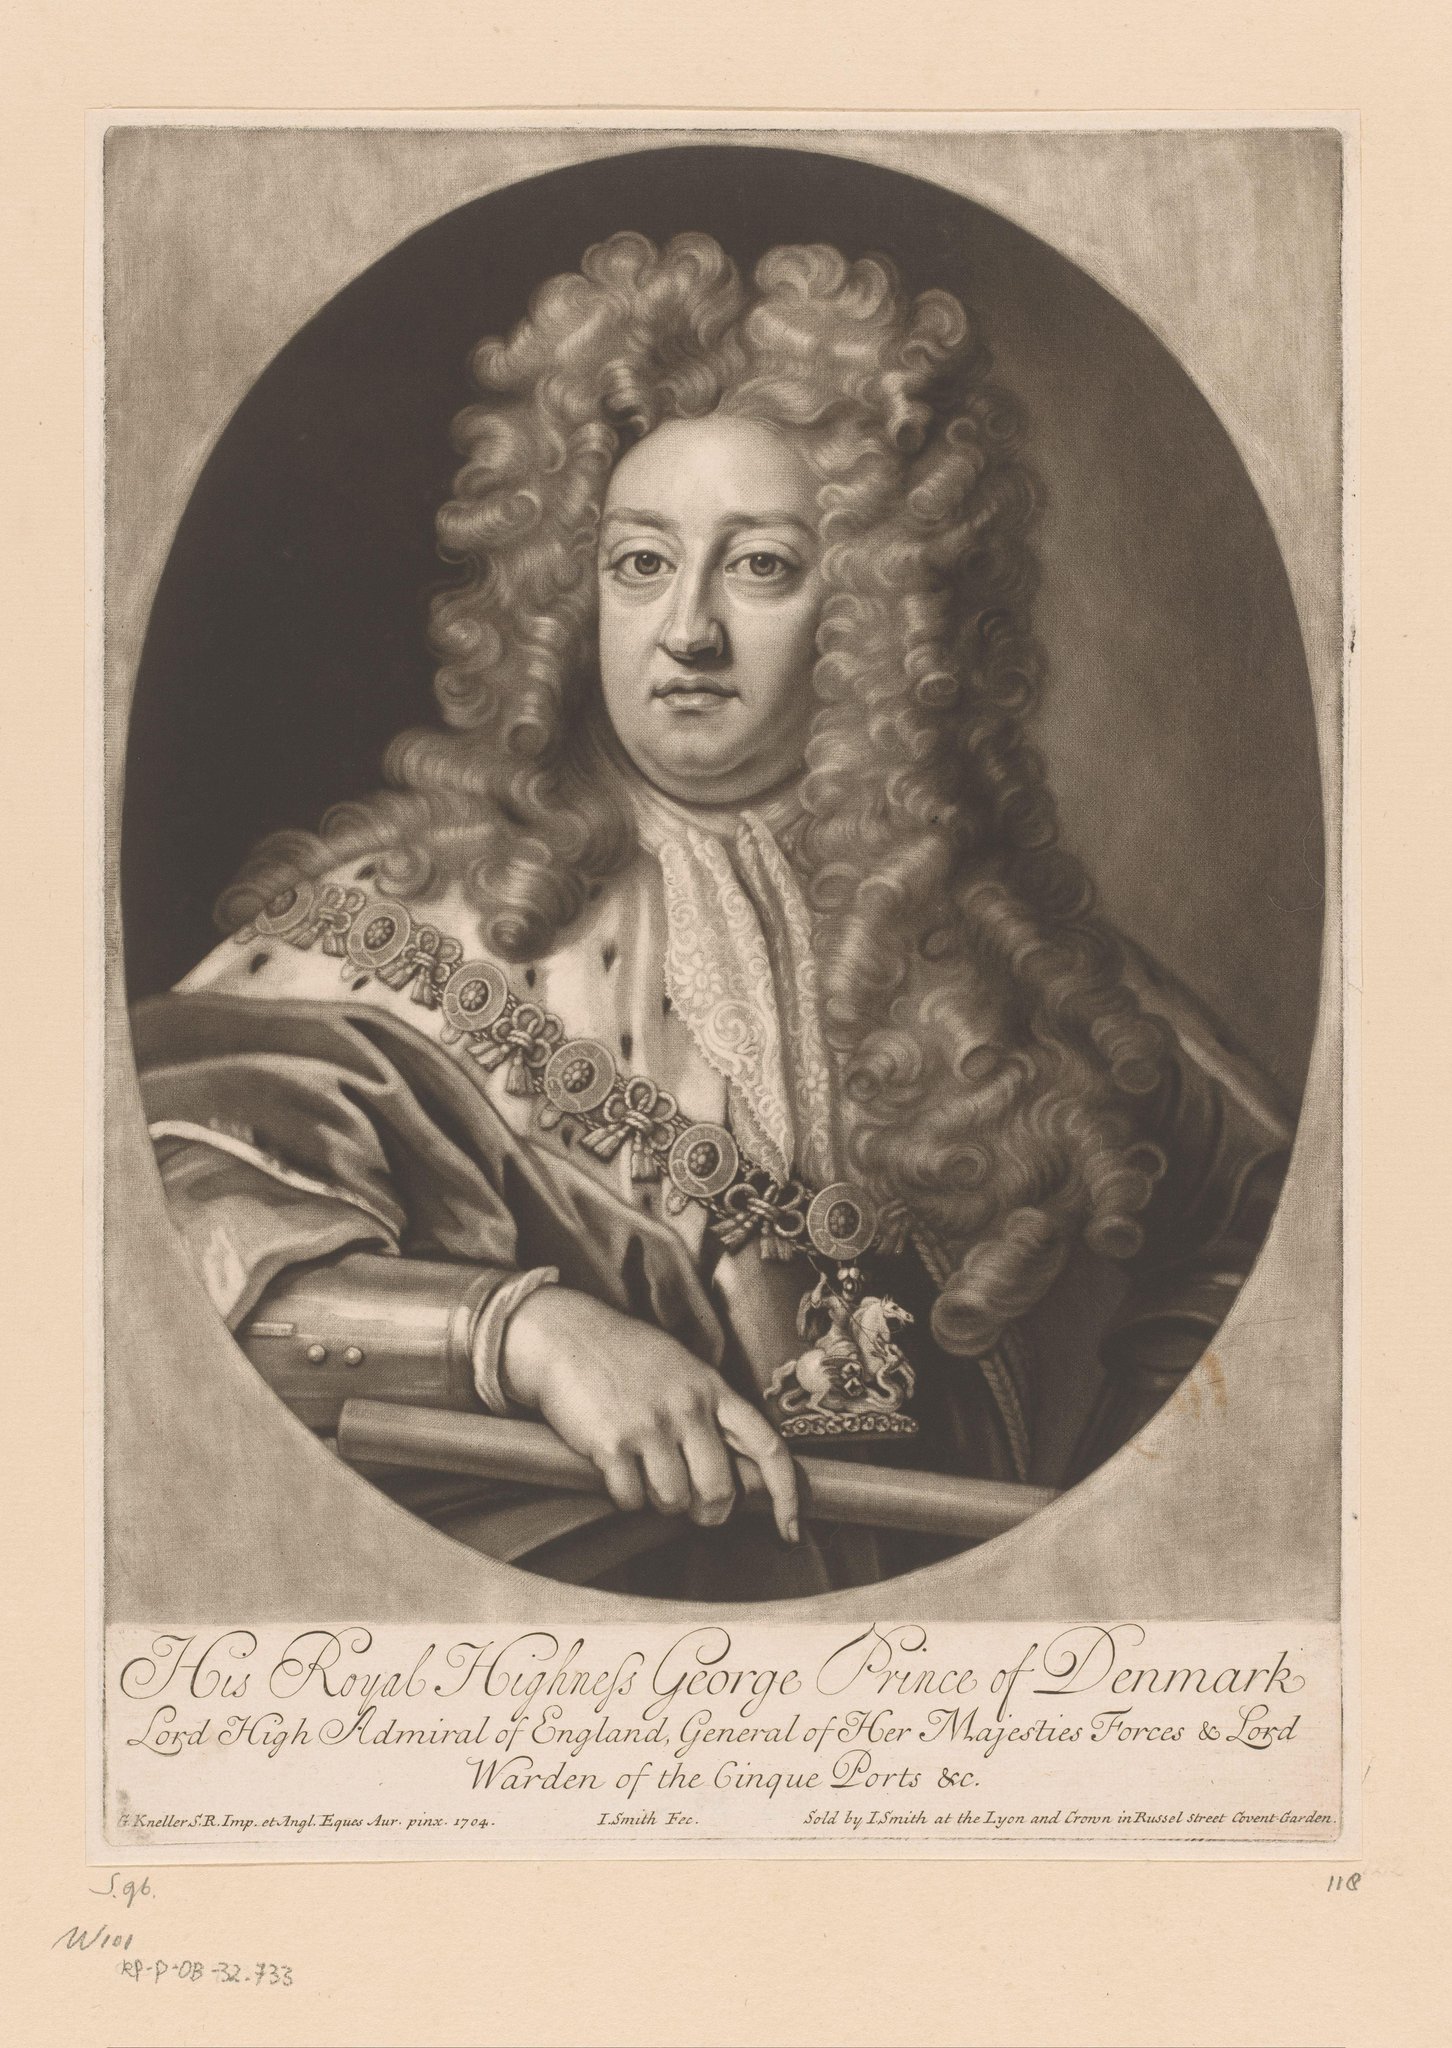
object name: print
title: Portret van George, prins van Denemarken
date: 1704-1742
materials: paper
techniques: mezzotint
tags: george (prins van denemarken), prince, historical persons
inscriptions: collector's mark: Lugt 240